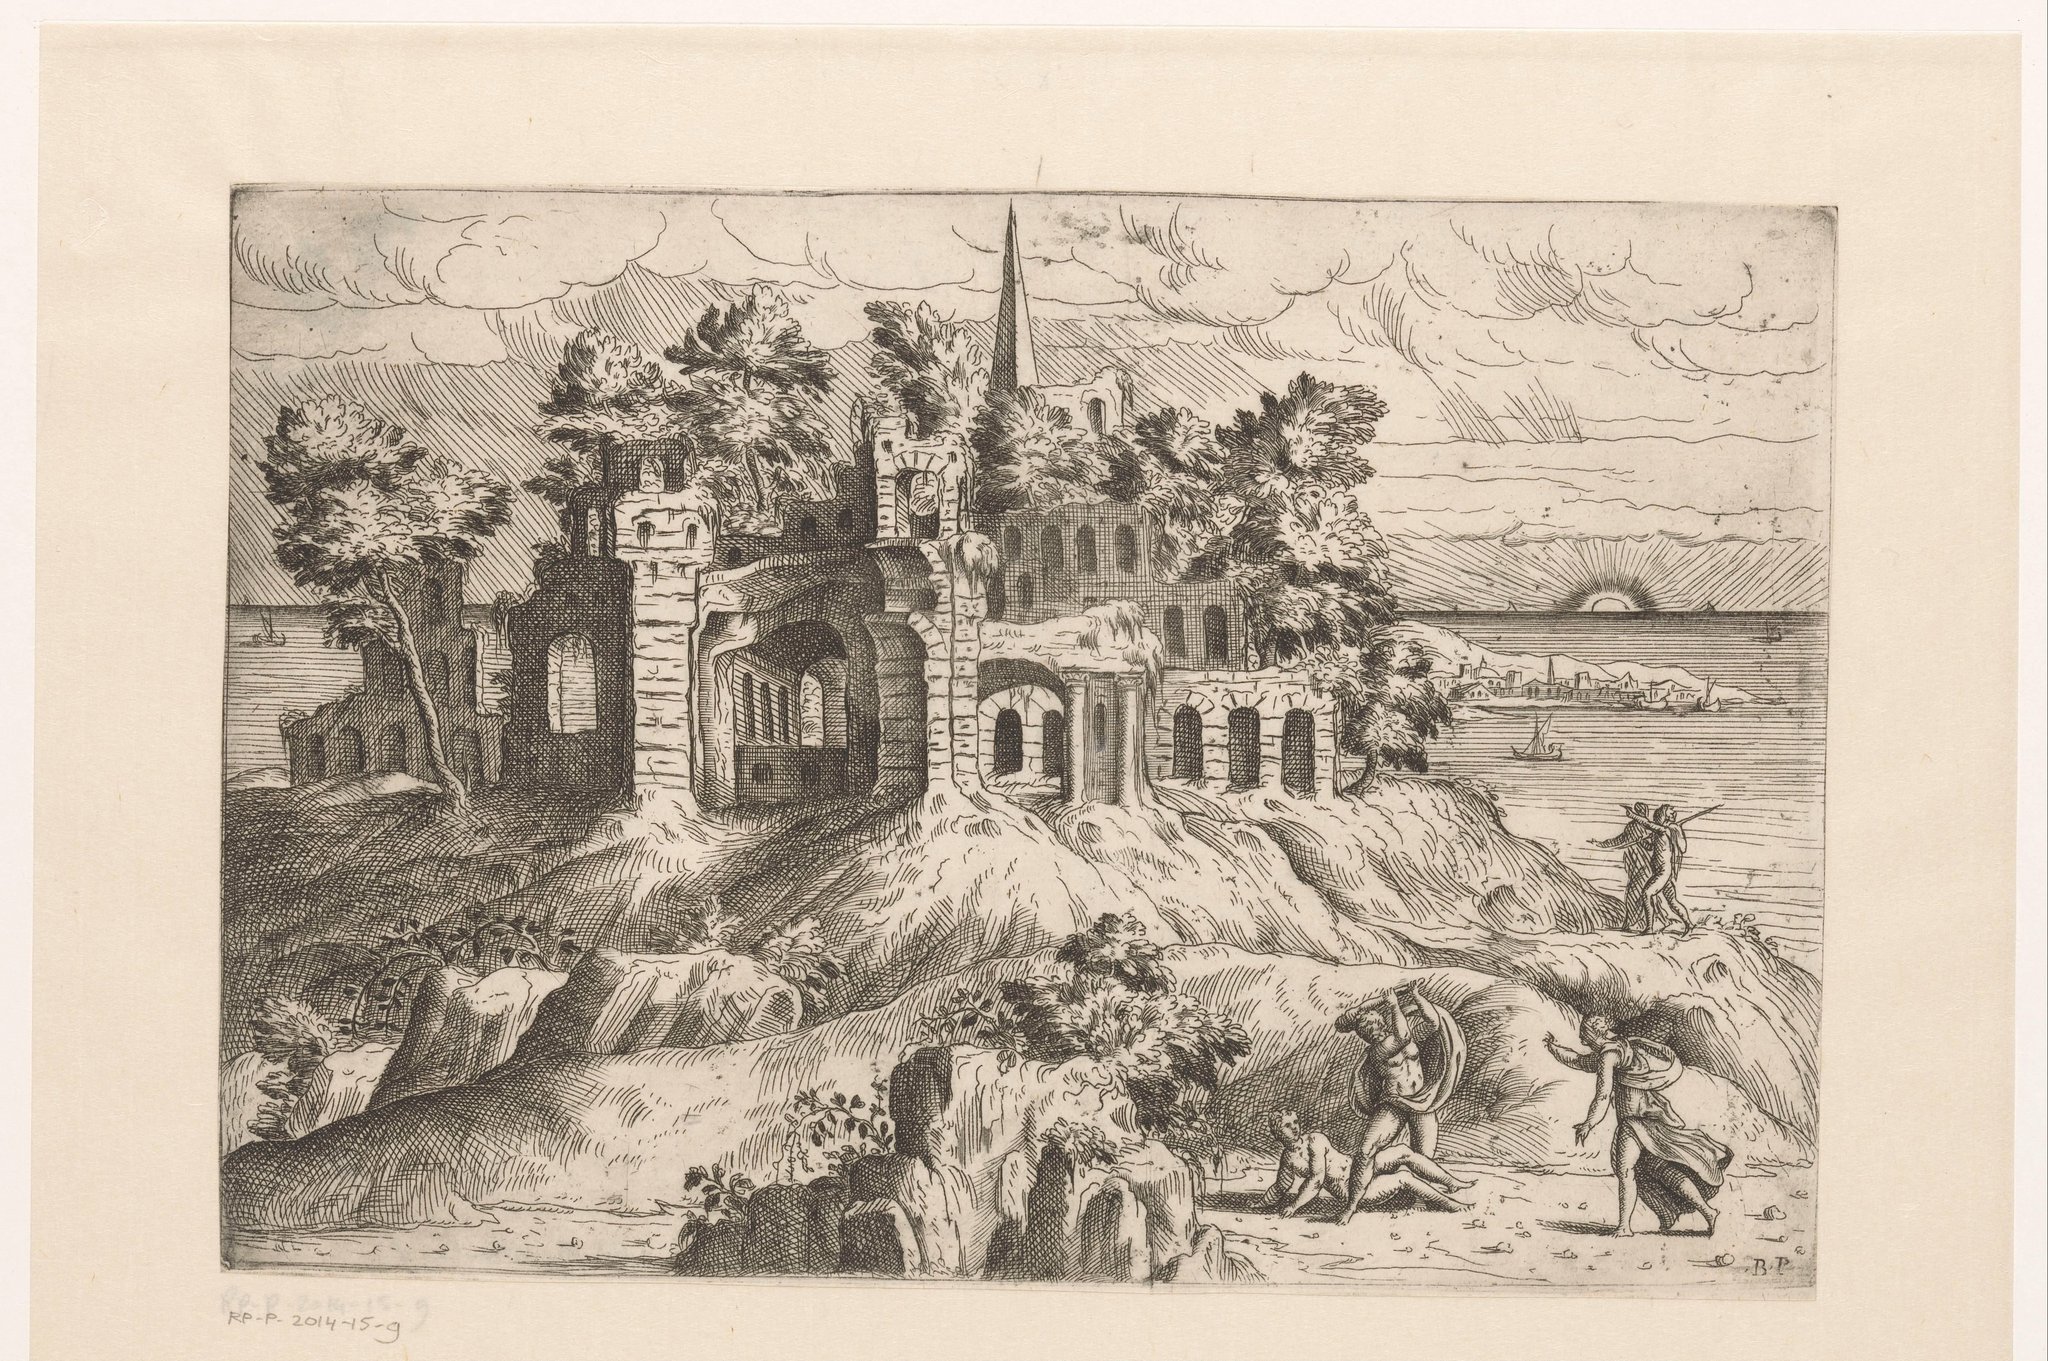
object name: print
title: Landschappen met ruïnes en fantasie-architectuur en figuren in antieke en exotische dracht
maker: giovanni battista pittoni (i)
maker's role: print maker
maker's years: 1520-1583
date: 1560-1570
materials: paper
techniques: etching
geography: vicenza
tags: landscape with ruins, fantastic architecture, unrealistic architectural fantasies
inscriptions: collector's mark: Lugt 2760, collector's mark: Lugt 2228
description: Vermoedelijk is deze prentreeks onbeschreven (vergelijk Passavant, deel 6 p. 169-170, nr. 1). Het is vooralsnog onduidelijk of de reeks compleet is of wellicht uit meer prenten bestond.